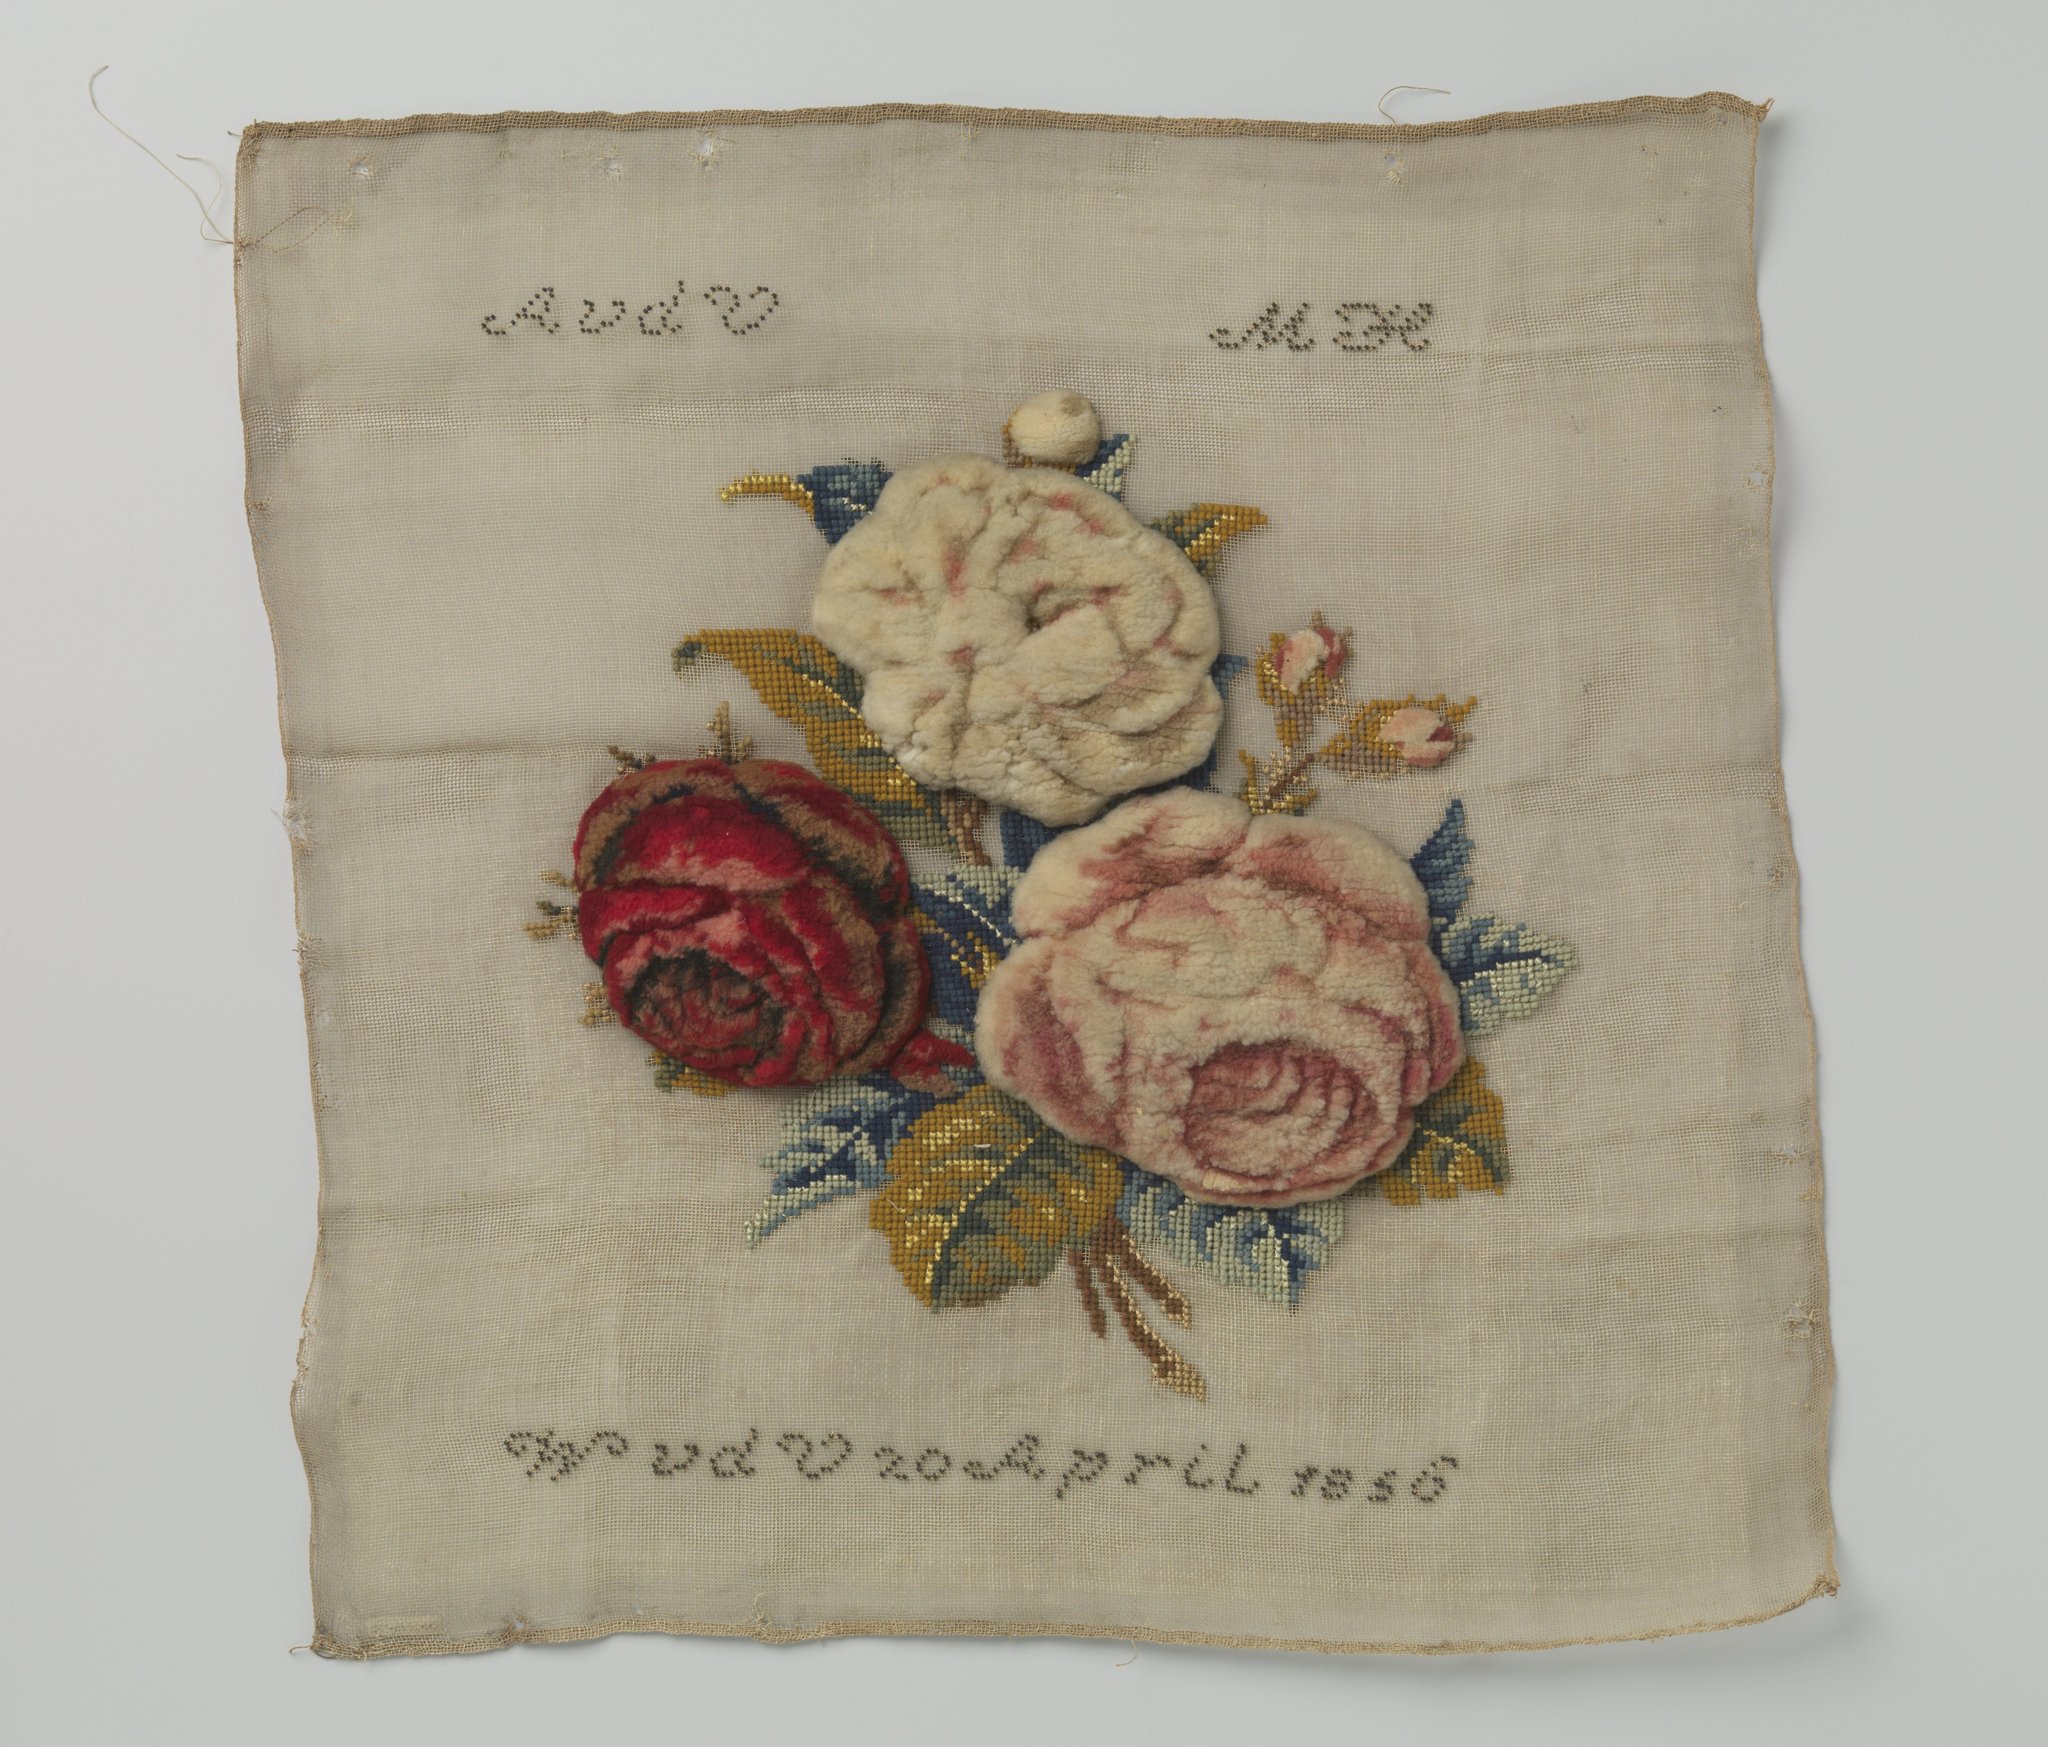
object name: embroidery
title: Kussenovertrek met Berlijns borduurwerk van drie zeer grote rozen omgeven door bladeren in kruissteek, gemerkt en gedateerd met kralen.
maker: Anonymous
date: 1856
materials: jet, linen, silk, wool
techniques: embroidery, embroidered, knotting, shaving, weave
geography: netherlands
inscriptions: initials: ‘WvdV...20 April 1856’, date: ‘WvdV...20 April 1856’, initials: ‘AvdV...MH’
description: Kussenovertrek met Berlijns borduurwerk van drie zeer grote rozen omgeven door bladeren in kruissteek, gemerkt en gedateerd met kralen. Grofmazig, linnen stramien met langs de zijkanten een zelfkant; boven en onder omgezoomd. De rozen zijn uitgevoerd in knoopwerk met een extra hoge pool en reliëf geschoren. Boven de rozen met zwarte (gitten?) kralen gewerkt 'AvdV' en 'MH', onder de rozen 'WvdV... 20 April 1856' .